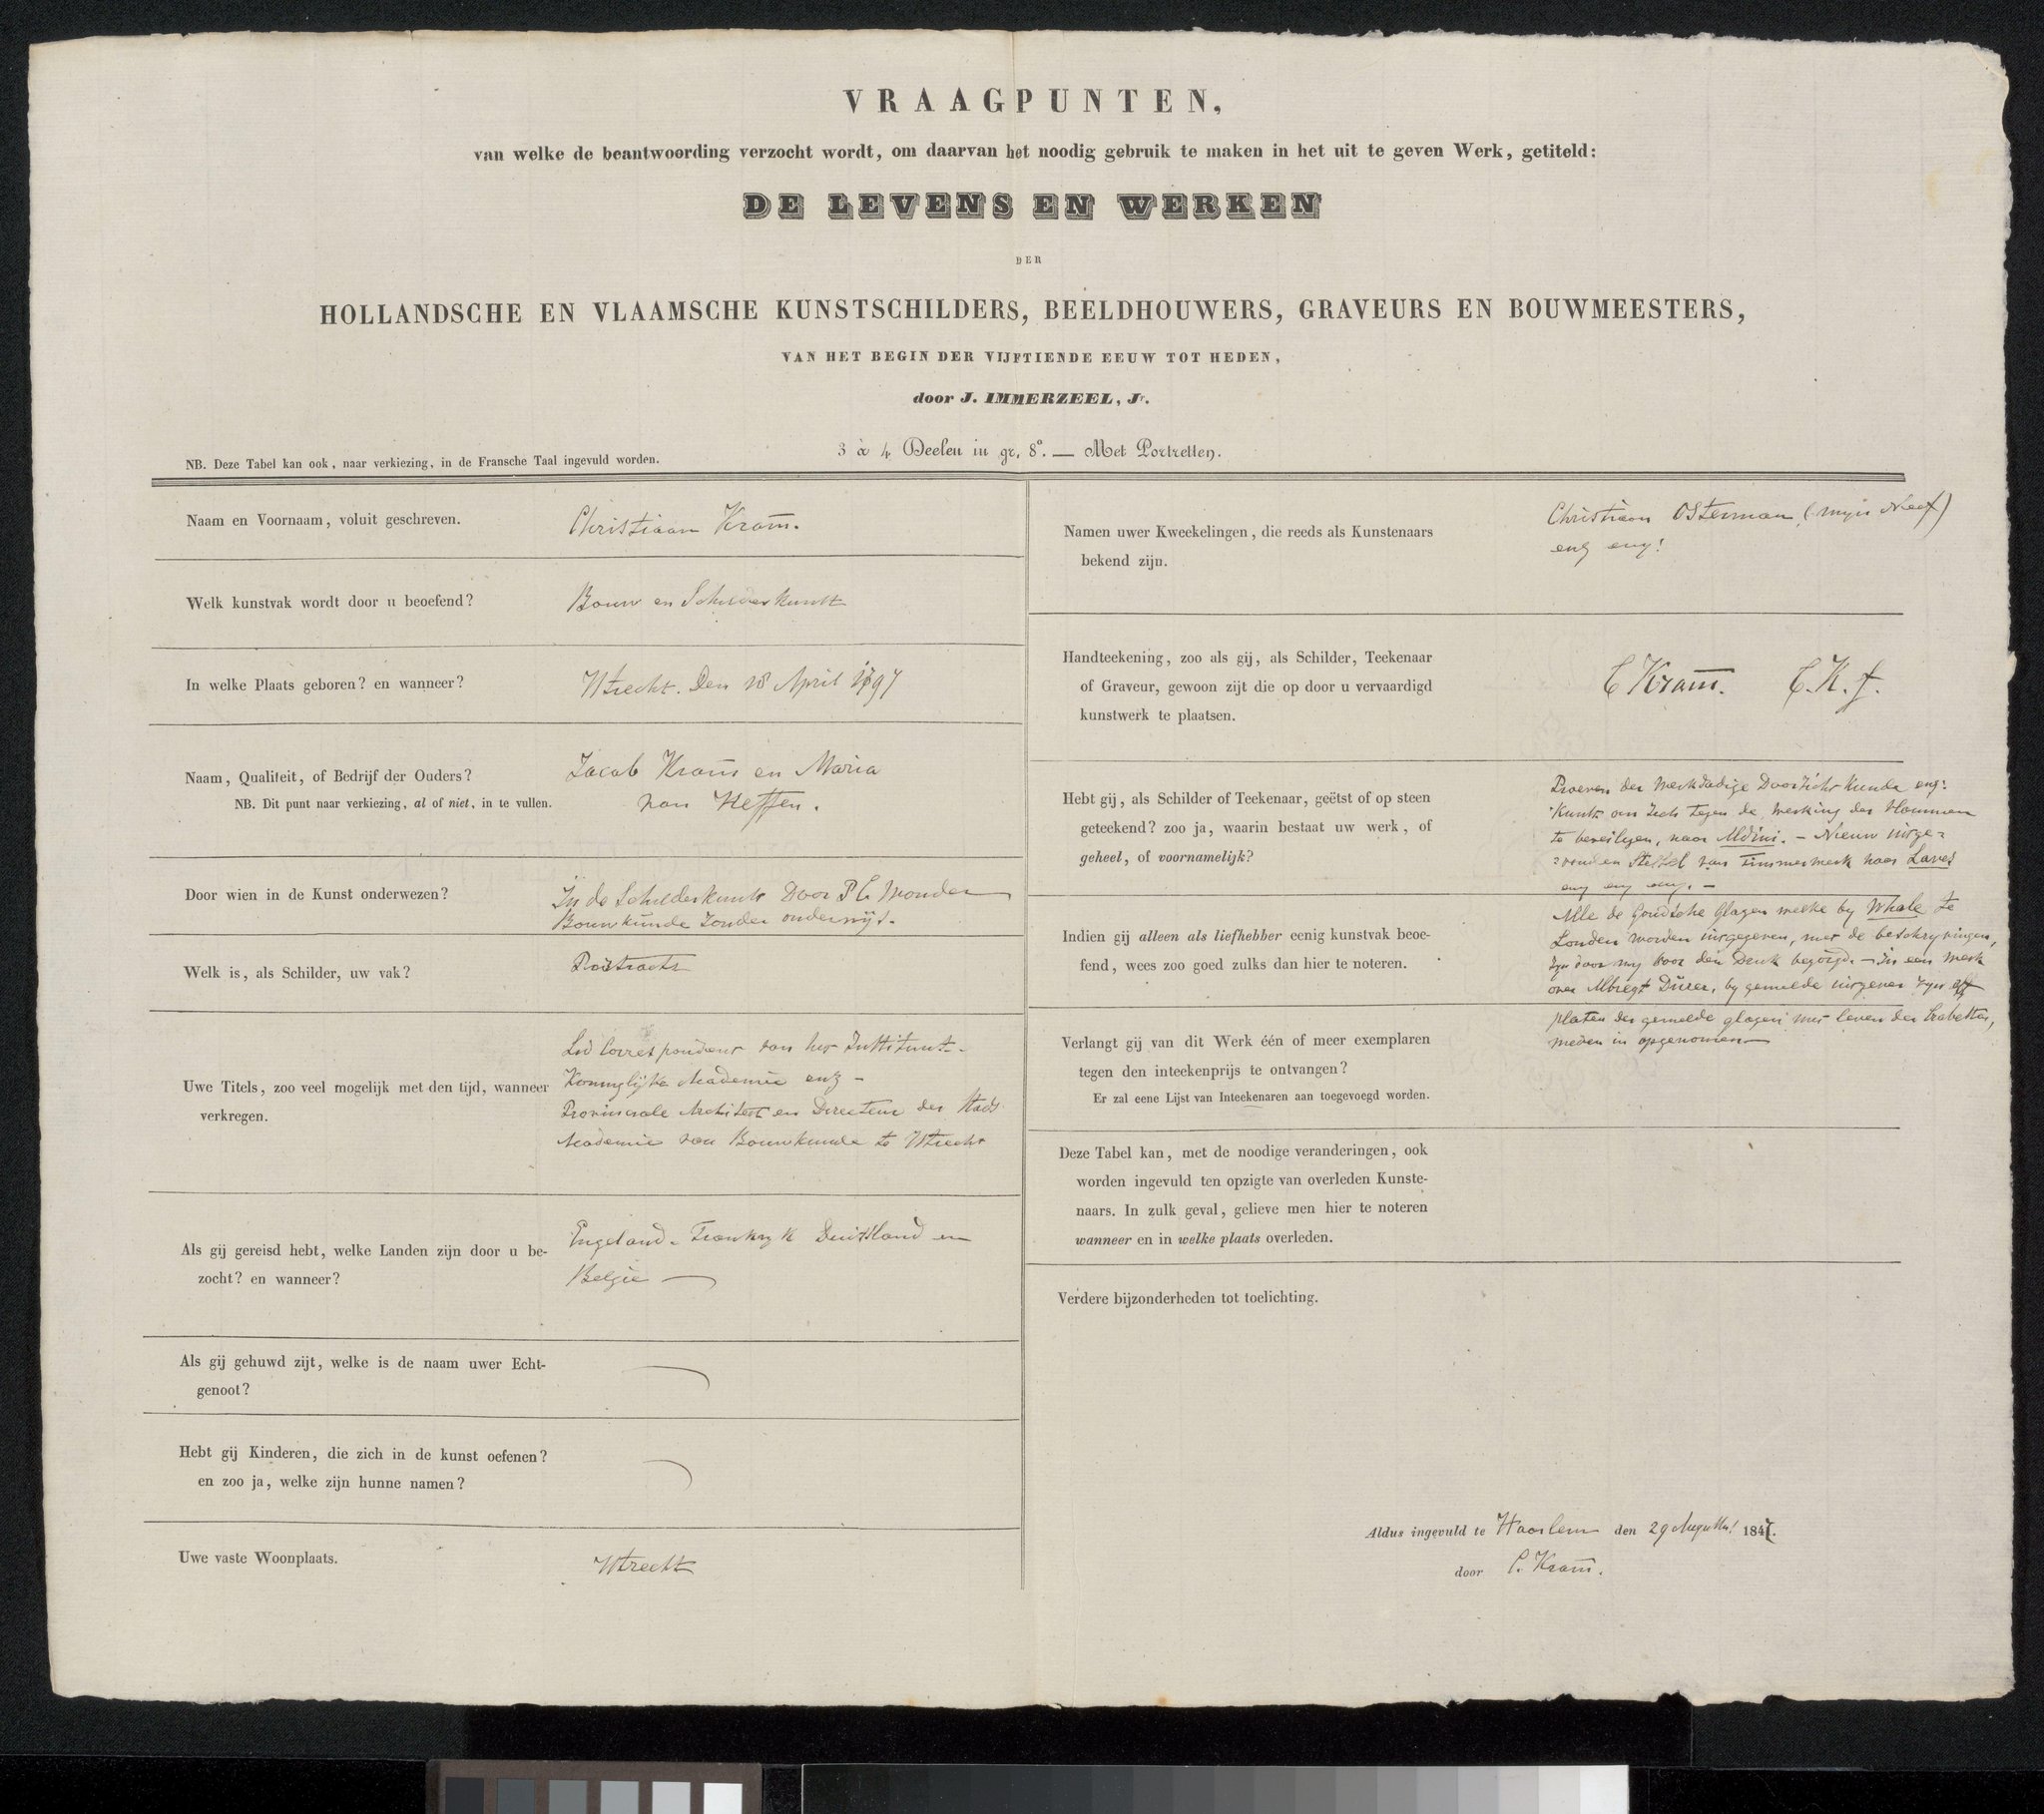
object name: questionnaire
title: Enquêteformulier ingevuld door Christiaan Kramm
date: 1847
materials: ink, paper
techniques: pen, printing, writing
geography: haarlem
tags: utrecht, draughtsman, christiaan kramm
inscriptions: inscription: ‘Vraagpunten,/ van welke de beantwoording verzocht wordt, om daarvan het noodig gebruik te maken in het uit te geven Werk, getiteld: De levens en werken/ der Hollandsche en Vlaamsche kunstschilders, beeldhouwers,/ graveurs en bouwmeesters, van het begin der vijftiende eeuw tot heden/ door J. Immerzeel, Jr.’, watermark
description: Opgenomen in: Immerzeel, J. Jr., De levens en werken der Hollandsche en Vlaamsche kunstschilders, beeldhouwers, graveurs en bouwmeesters, van het begin der vijftiende eeuw tot heden, Amsterdam: J.C. van Kesteren, 1842-1843.